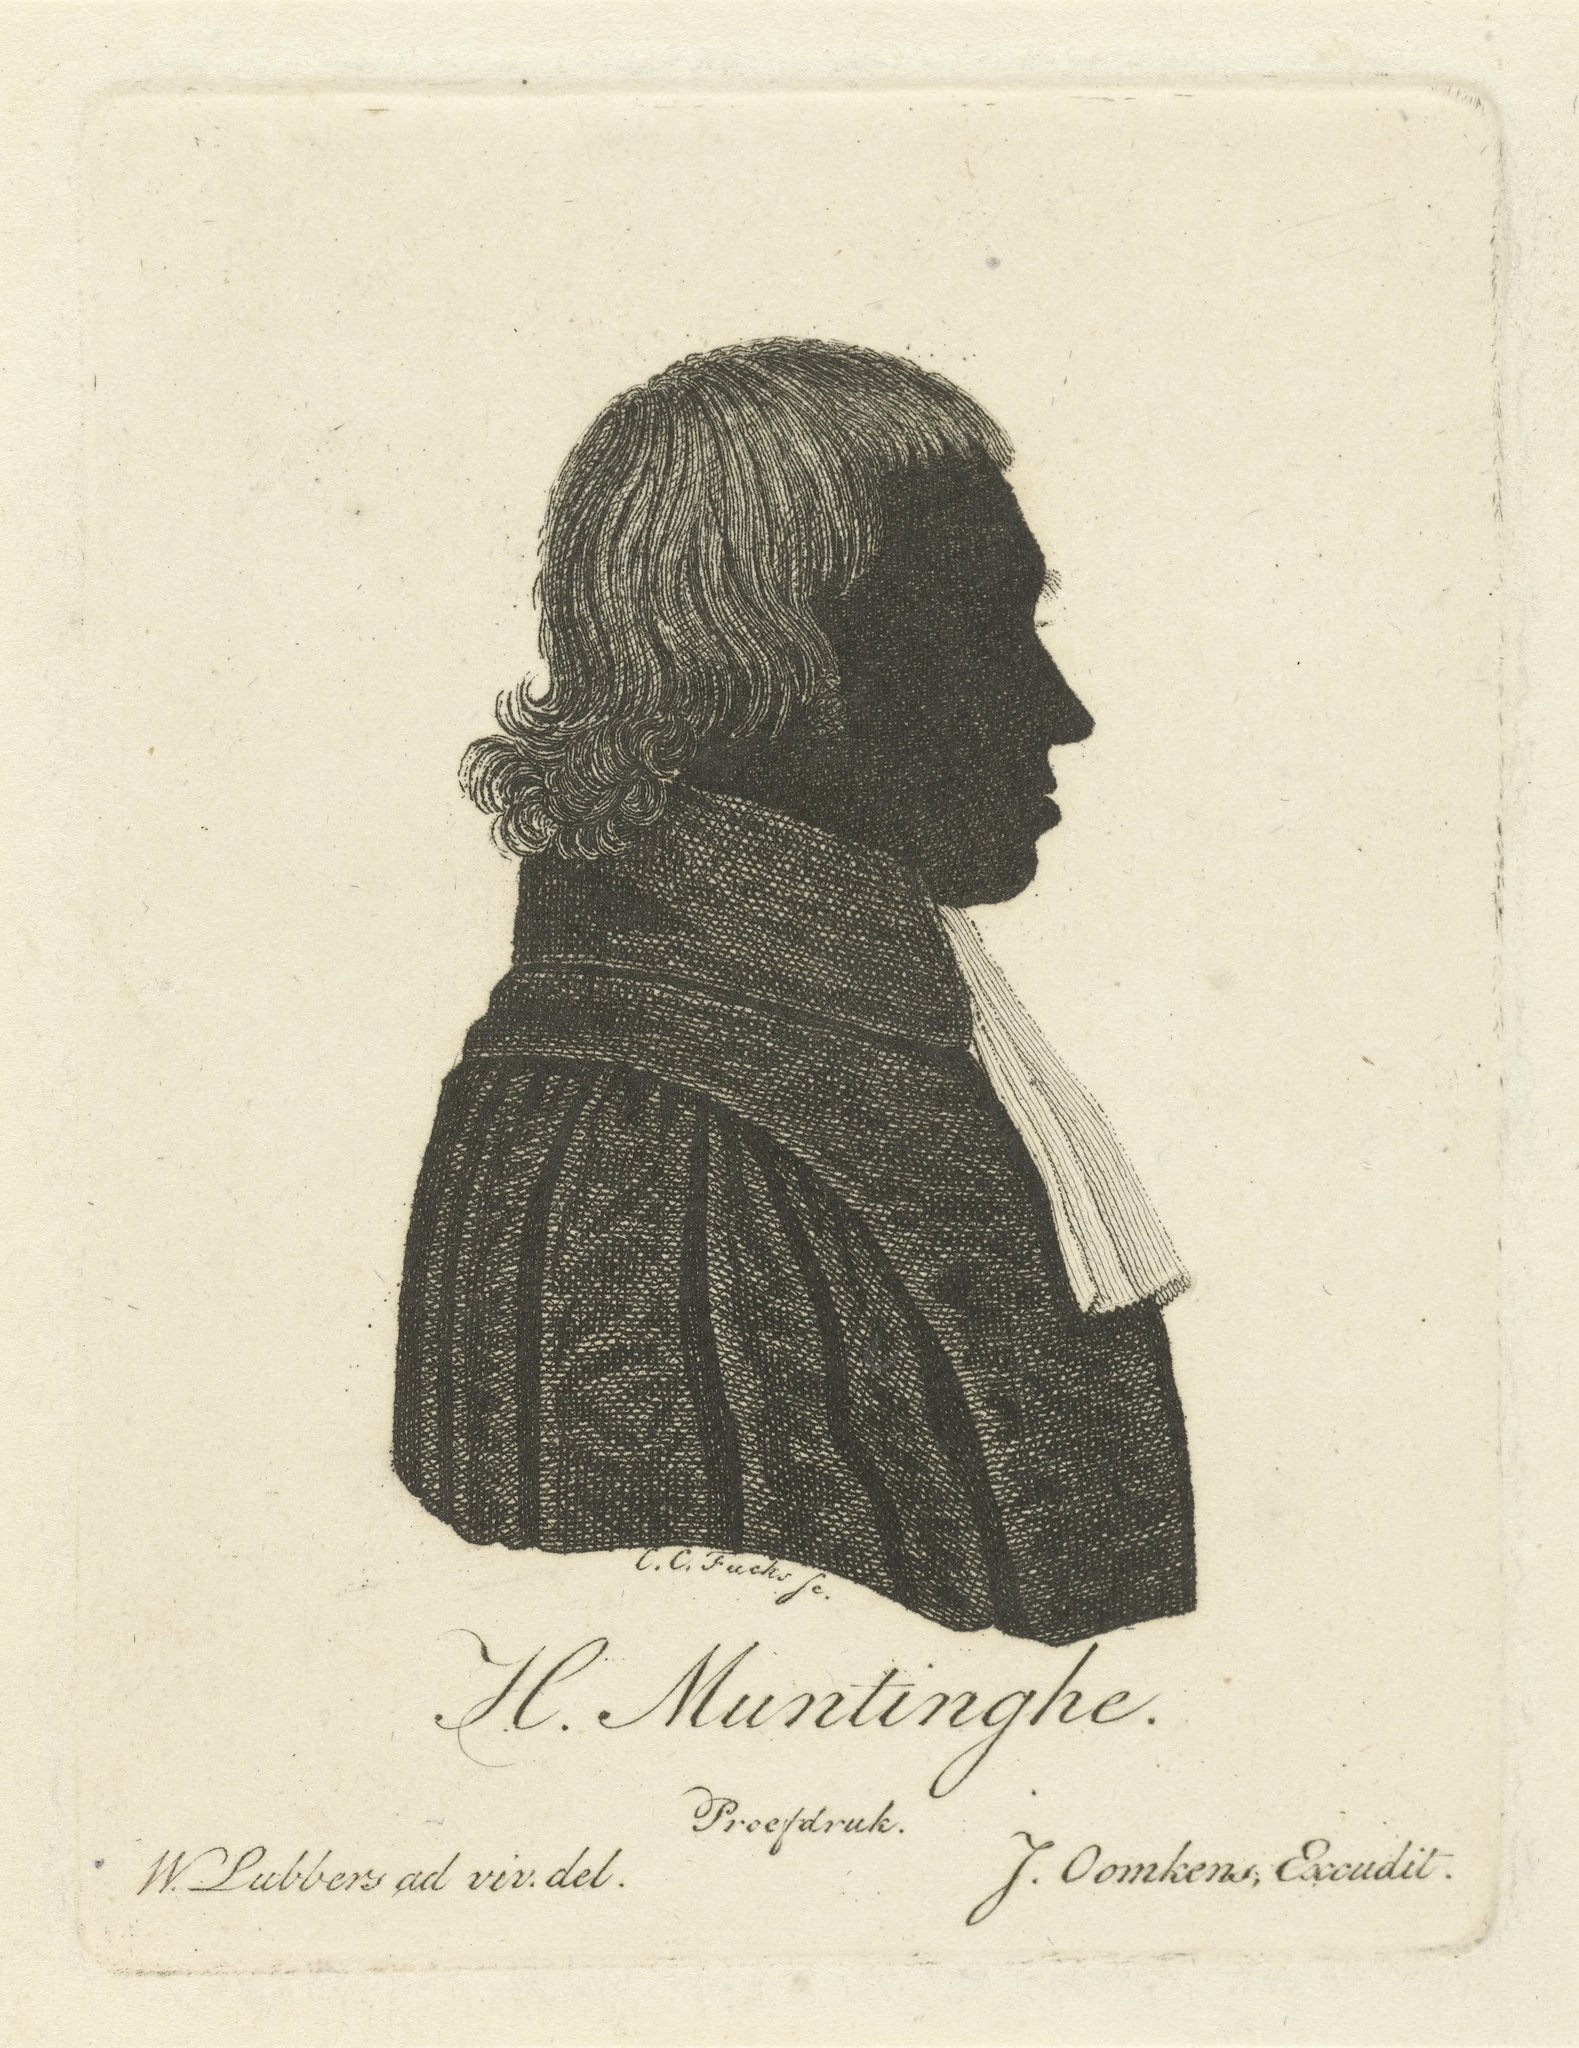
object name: print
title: Silhouetportret van Herman Muntinghe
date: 1808-1844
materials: paper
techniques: etching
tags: termunten, professor in de theologie, herman muntinghe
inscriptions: collector's mark: Lugt 2228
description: Silhouetportret van Herman Muntinghe, buste naar rechts.